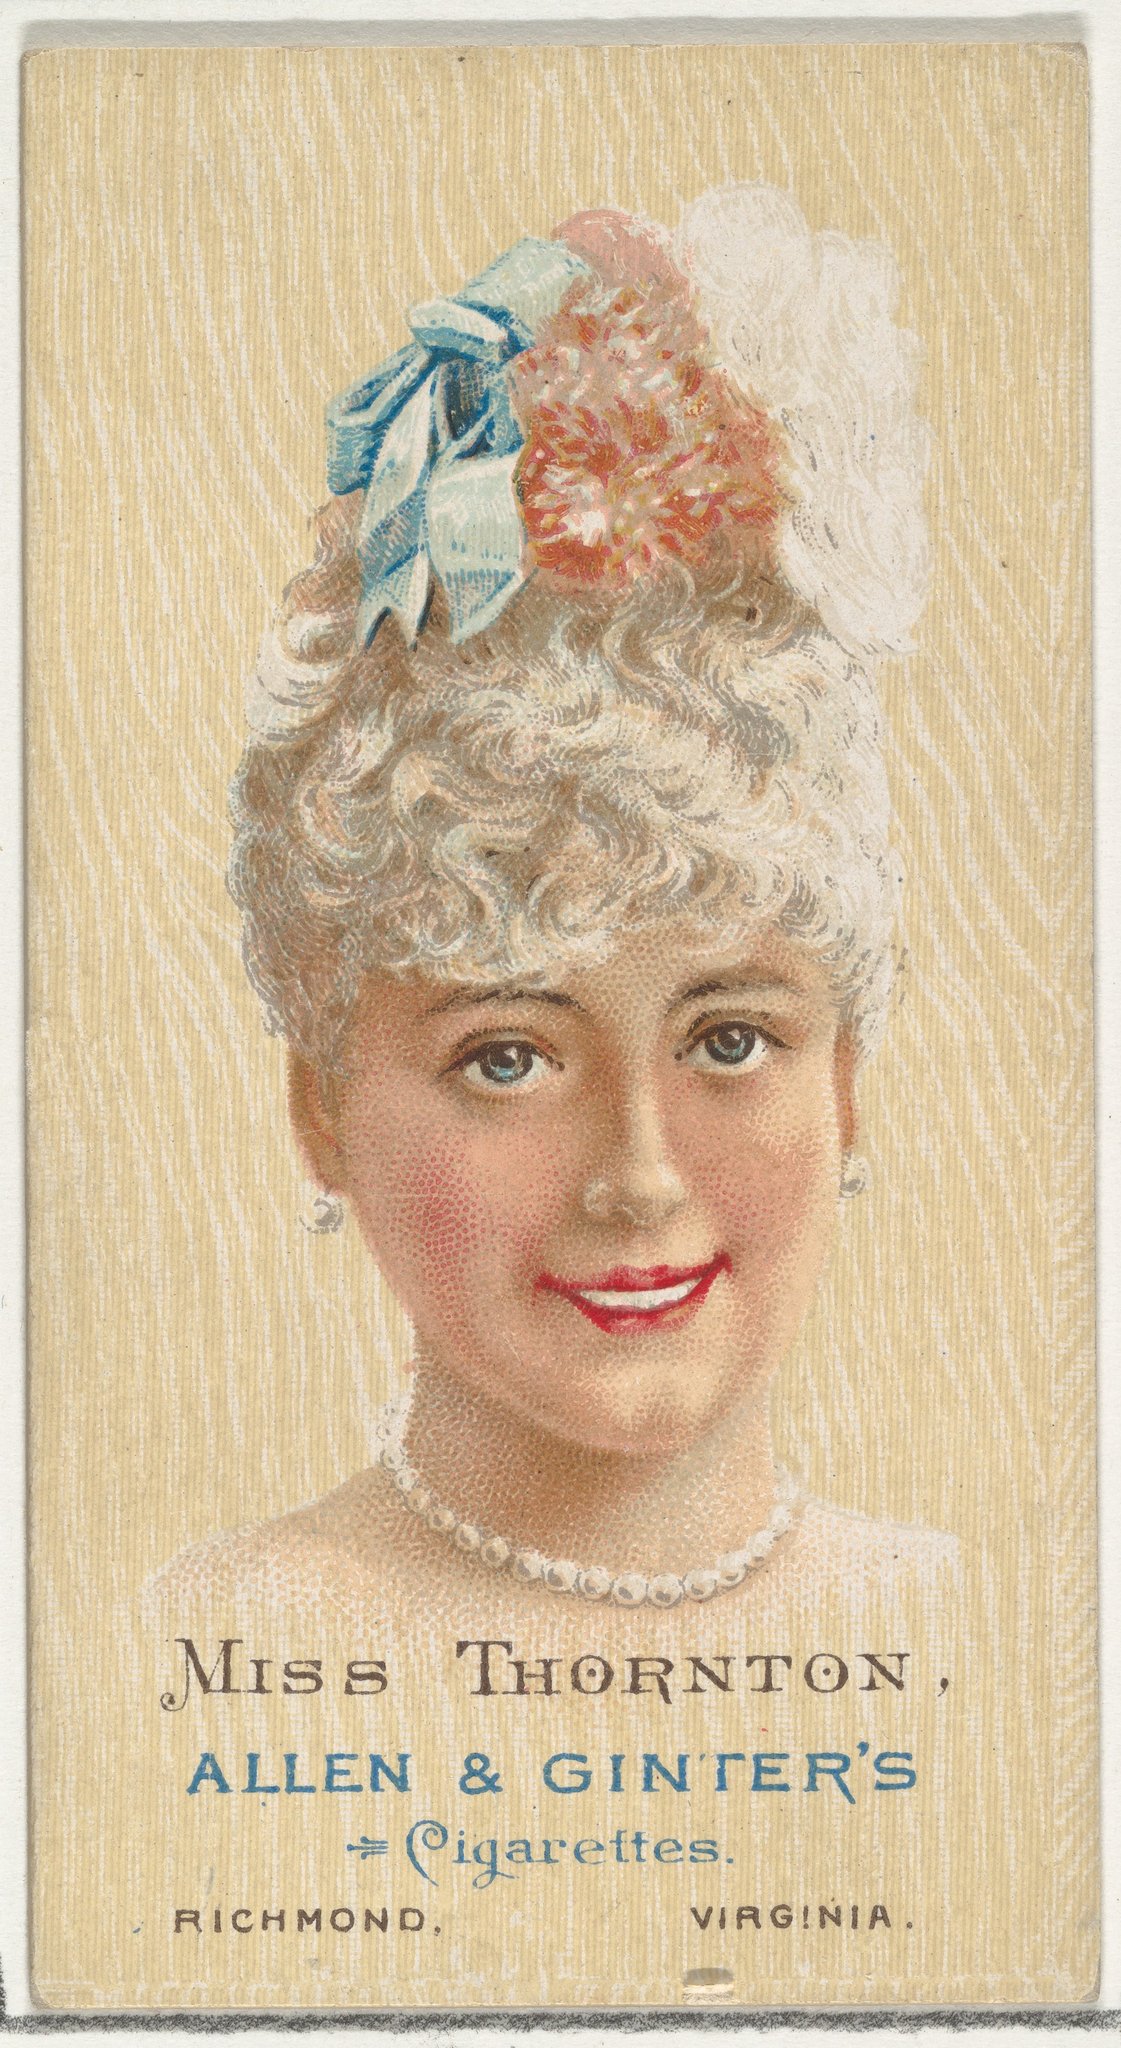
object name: print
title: Miss Thornton, from World's Beauties, Series 2 (N27) for Allen & Ginter Cigarettes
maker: allen & ginter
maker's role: publisher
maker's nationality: american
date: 1888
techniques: color lithograph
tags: women